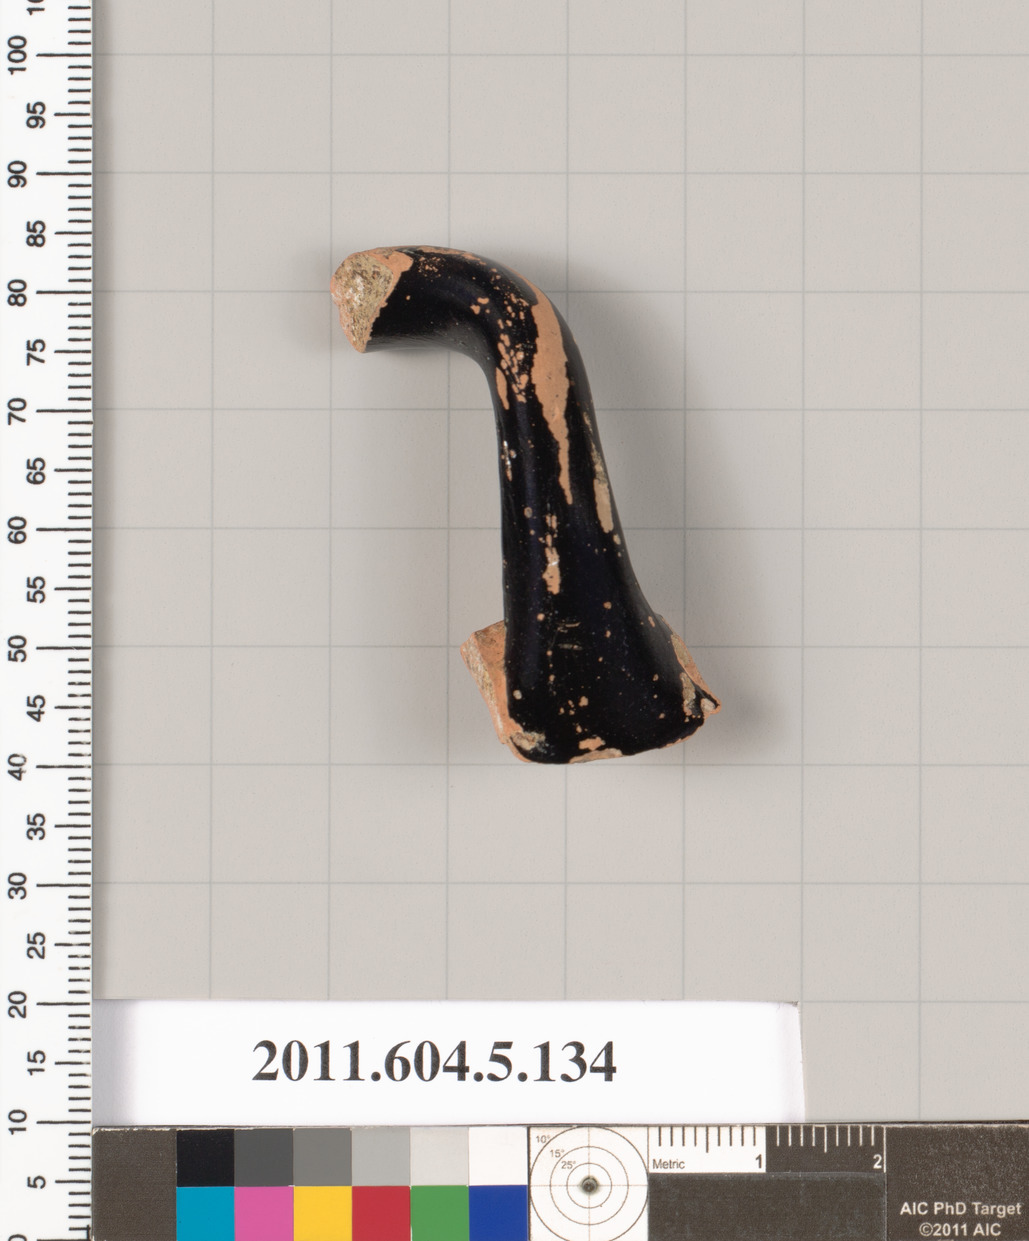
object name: kylix fragment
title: Terracotta fragment of a kylix (drinking cup)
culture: greek, attic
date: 470-450 BCE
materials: terracotta